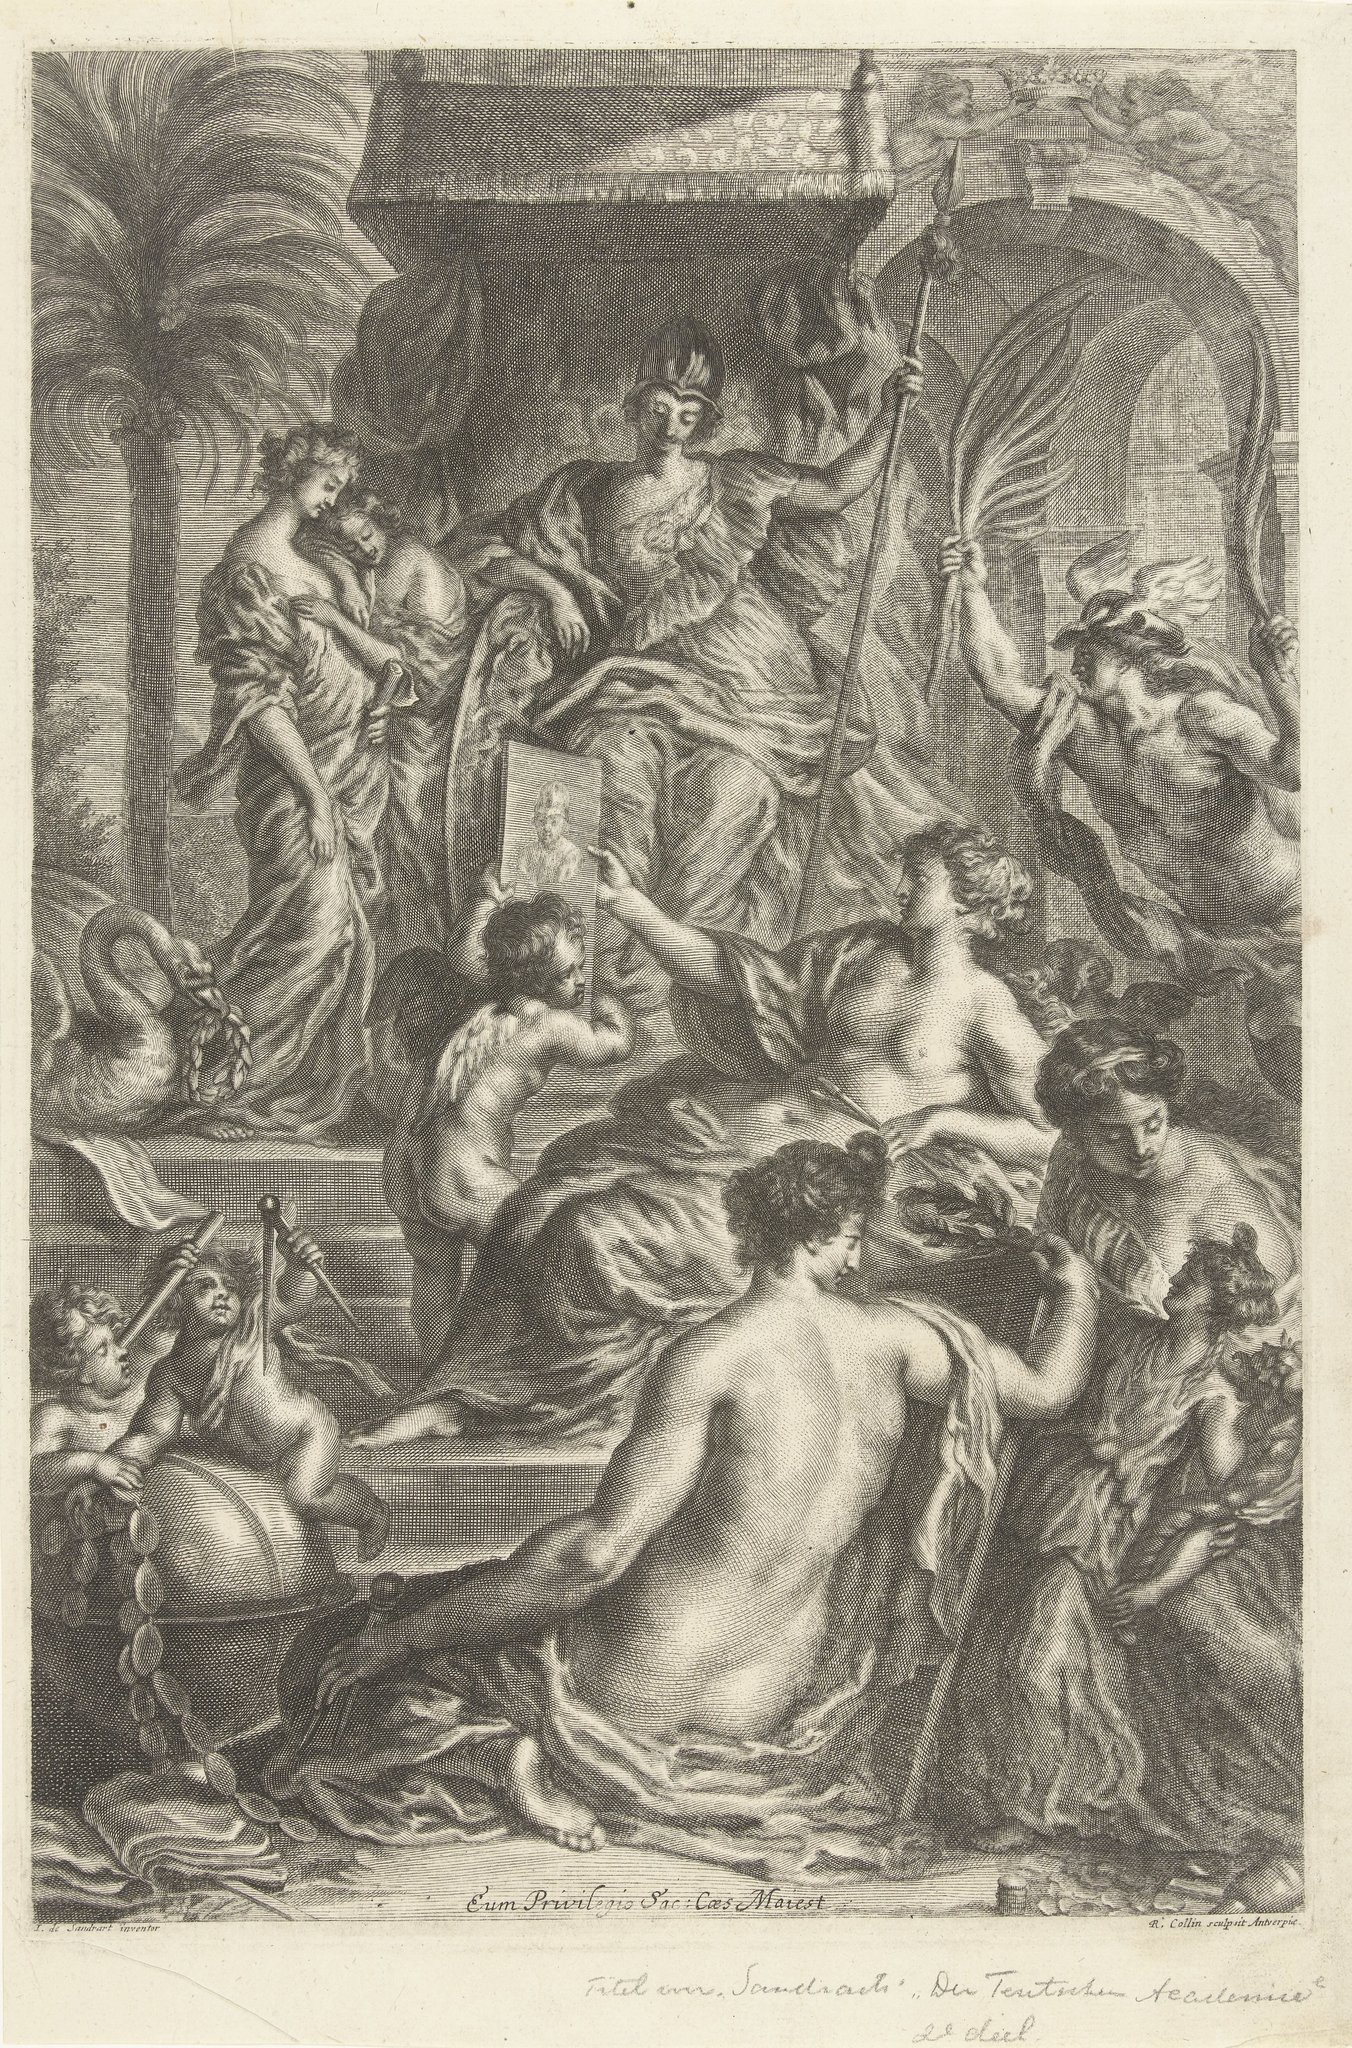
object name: print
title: Minerva troont tussen de Kunsten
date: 1676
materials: paper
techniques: engraving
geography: antwerp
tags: 'pictura', symbolic representations, allegories and emblems ~ painting; 'pittura' (ripa), 'sculptura', symbolic representations, allegories and emblems ~ sculpture; 'scoltura' (ripa), symbolic representations, allegories and emblems ~ poetry; 'poesia' (ripa), 'architectura', symbolic representations, allegories and emblems ~ architecture; 'architettura' (ripa), specific aspects, allegorical aspects of mercury; mercury as patron, specific aspects, allegorical aspects of minerva; minerva as patroness - veneration, honoured by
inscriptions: collector's mark: Lugt 2228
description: Minerva zit op haar troon in de Olymp. Links van haar staat de Poëzie met een zwaan, rechts komt Mercurius met palmtakken naar Minerva toe gelopen. Op de trappen van Minerva's troon zitten de Schilderkunst, de Beeldhouwkunst en de Architectuur te werken.